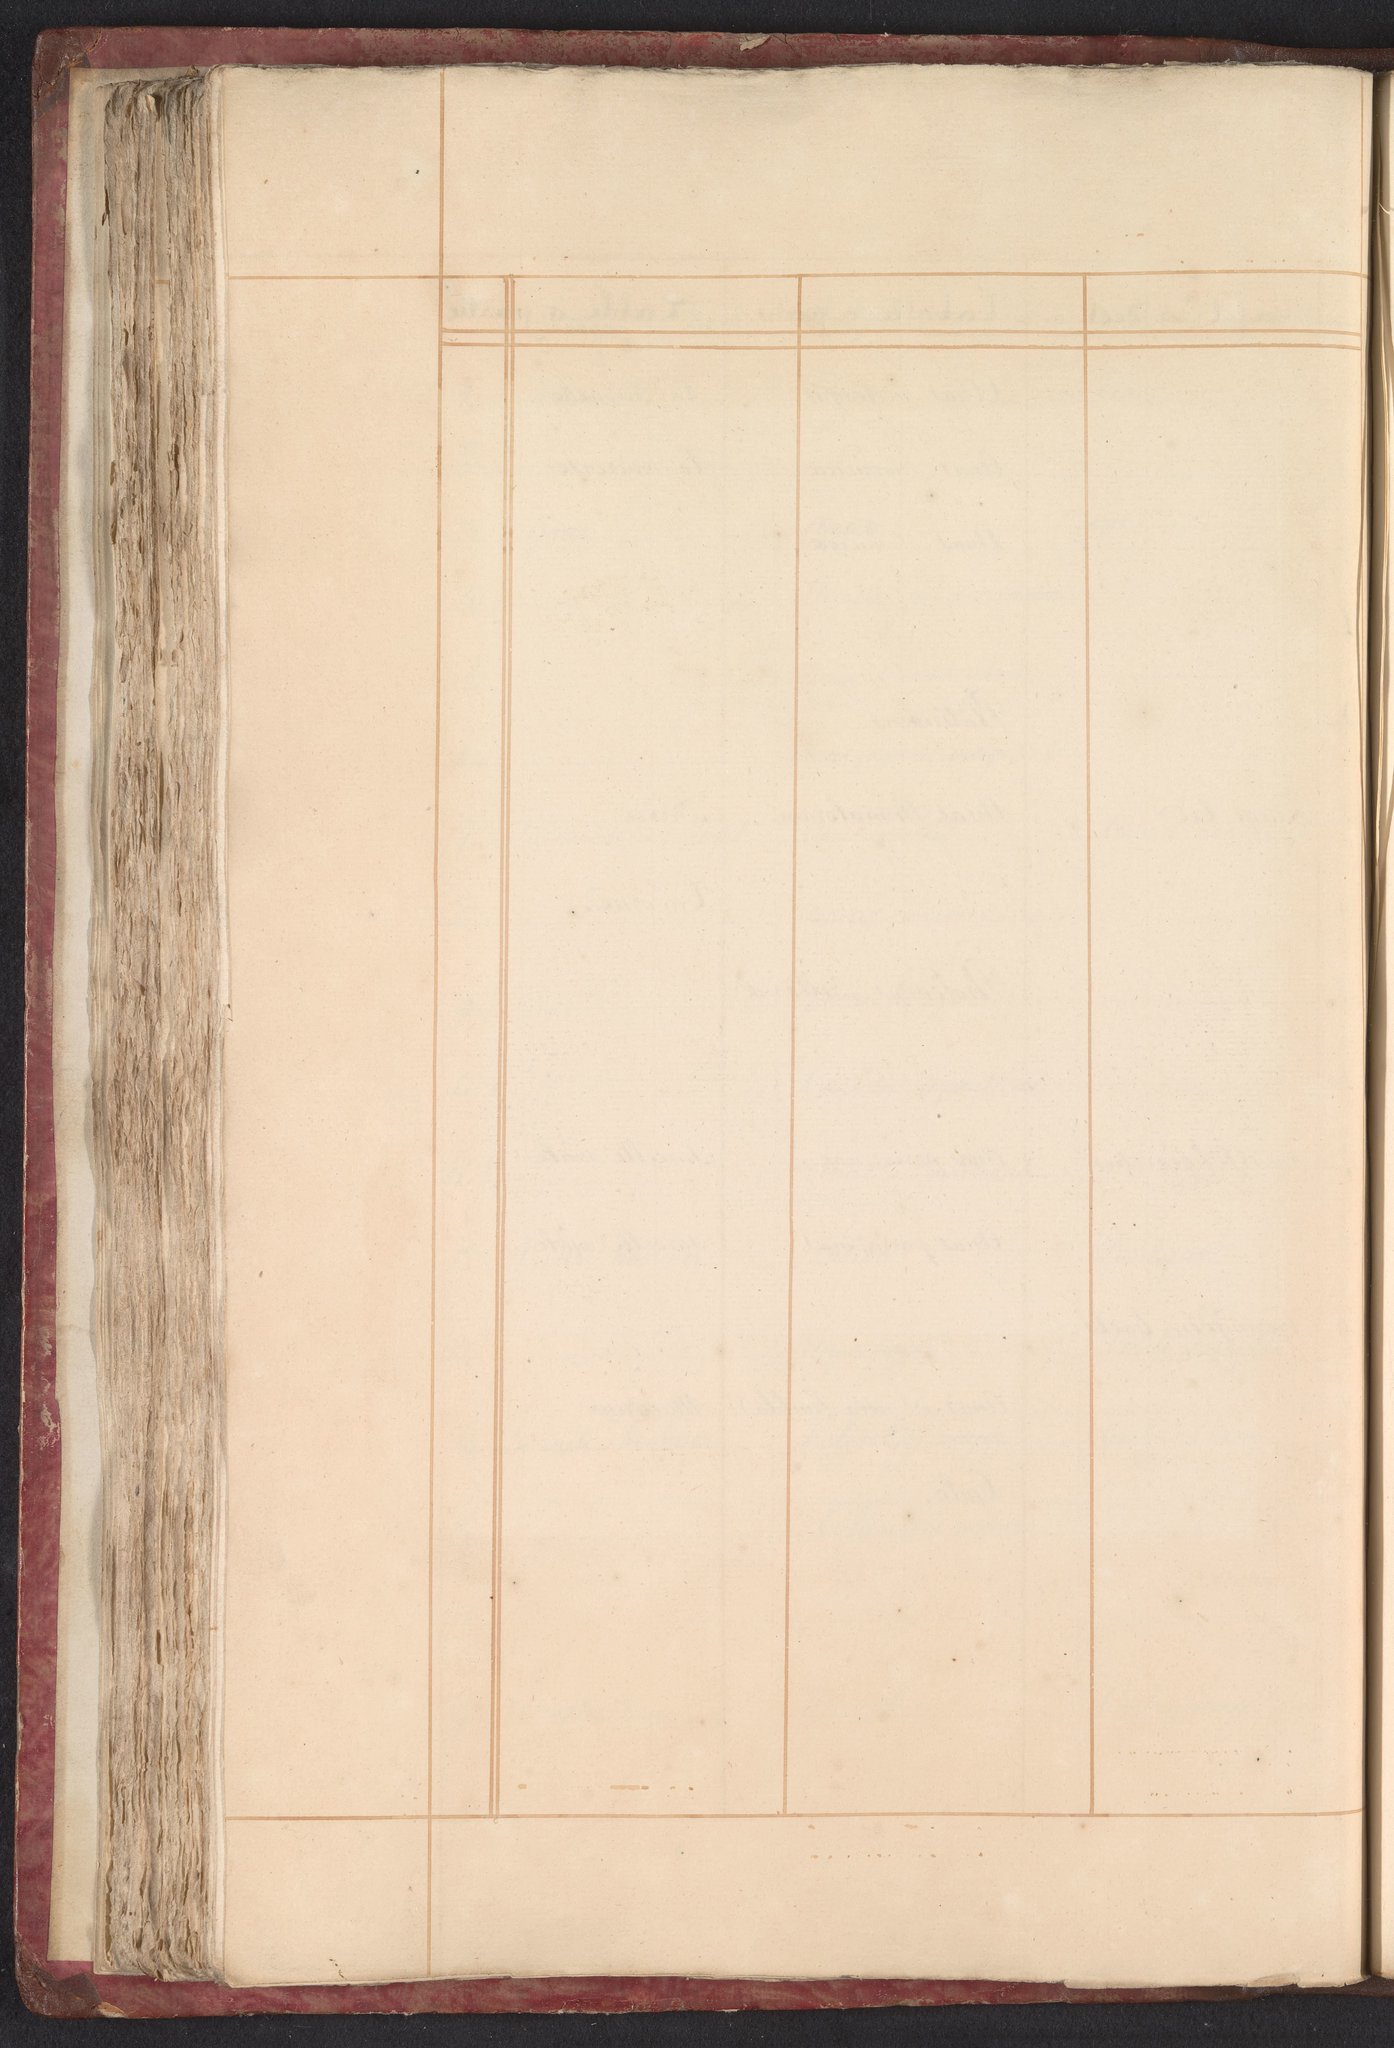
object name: manuscript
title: Oningevuld schema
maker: joseph van huerne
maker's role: kunstliefhebber, mecenas, verzamelaar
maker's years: 1752-1844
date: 1809-1814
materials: ink, paper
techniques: handwriting, pen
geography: bruges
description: Oningevuld schema met drie kolommen. Onderdeel van het derde album met tekeningen van vogels. Vijfde van twaalf albums met tekeningen van dieren, vogels en planten bekend rond 1600, gemaakt in opdracht van keizer Rudolf II. Met toelichting in Nederlands, Latijn en Frans.